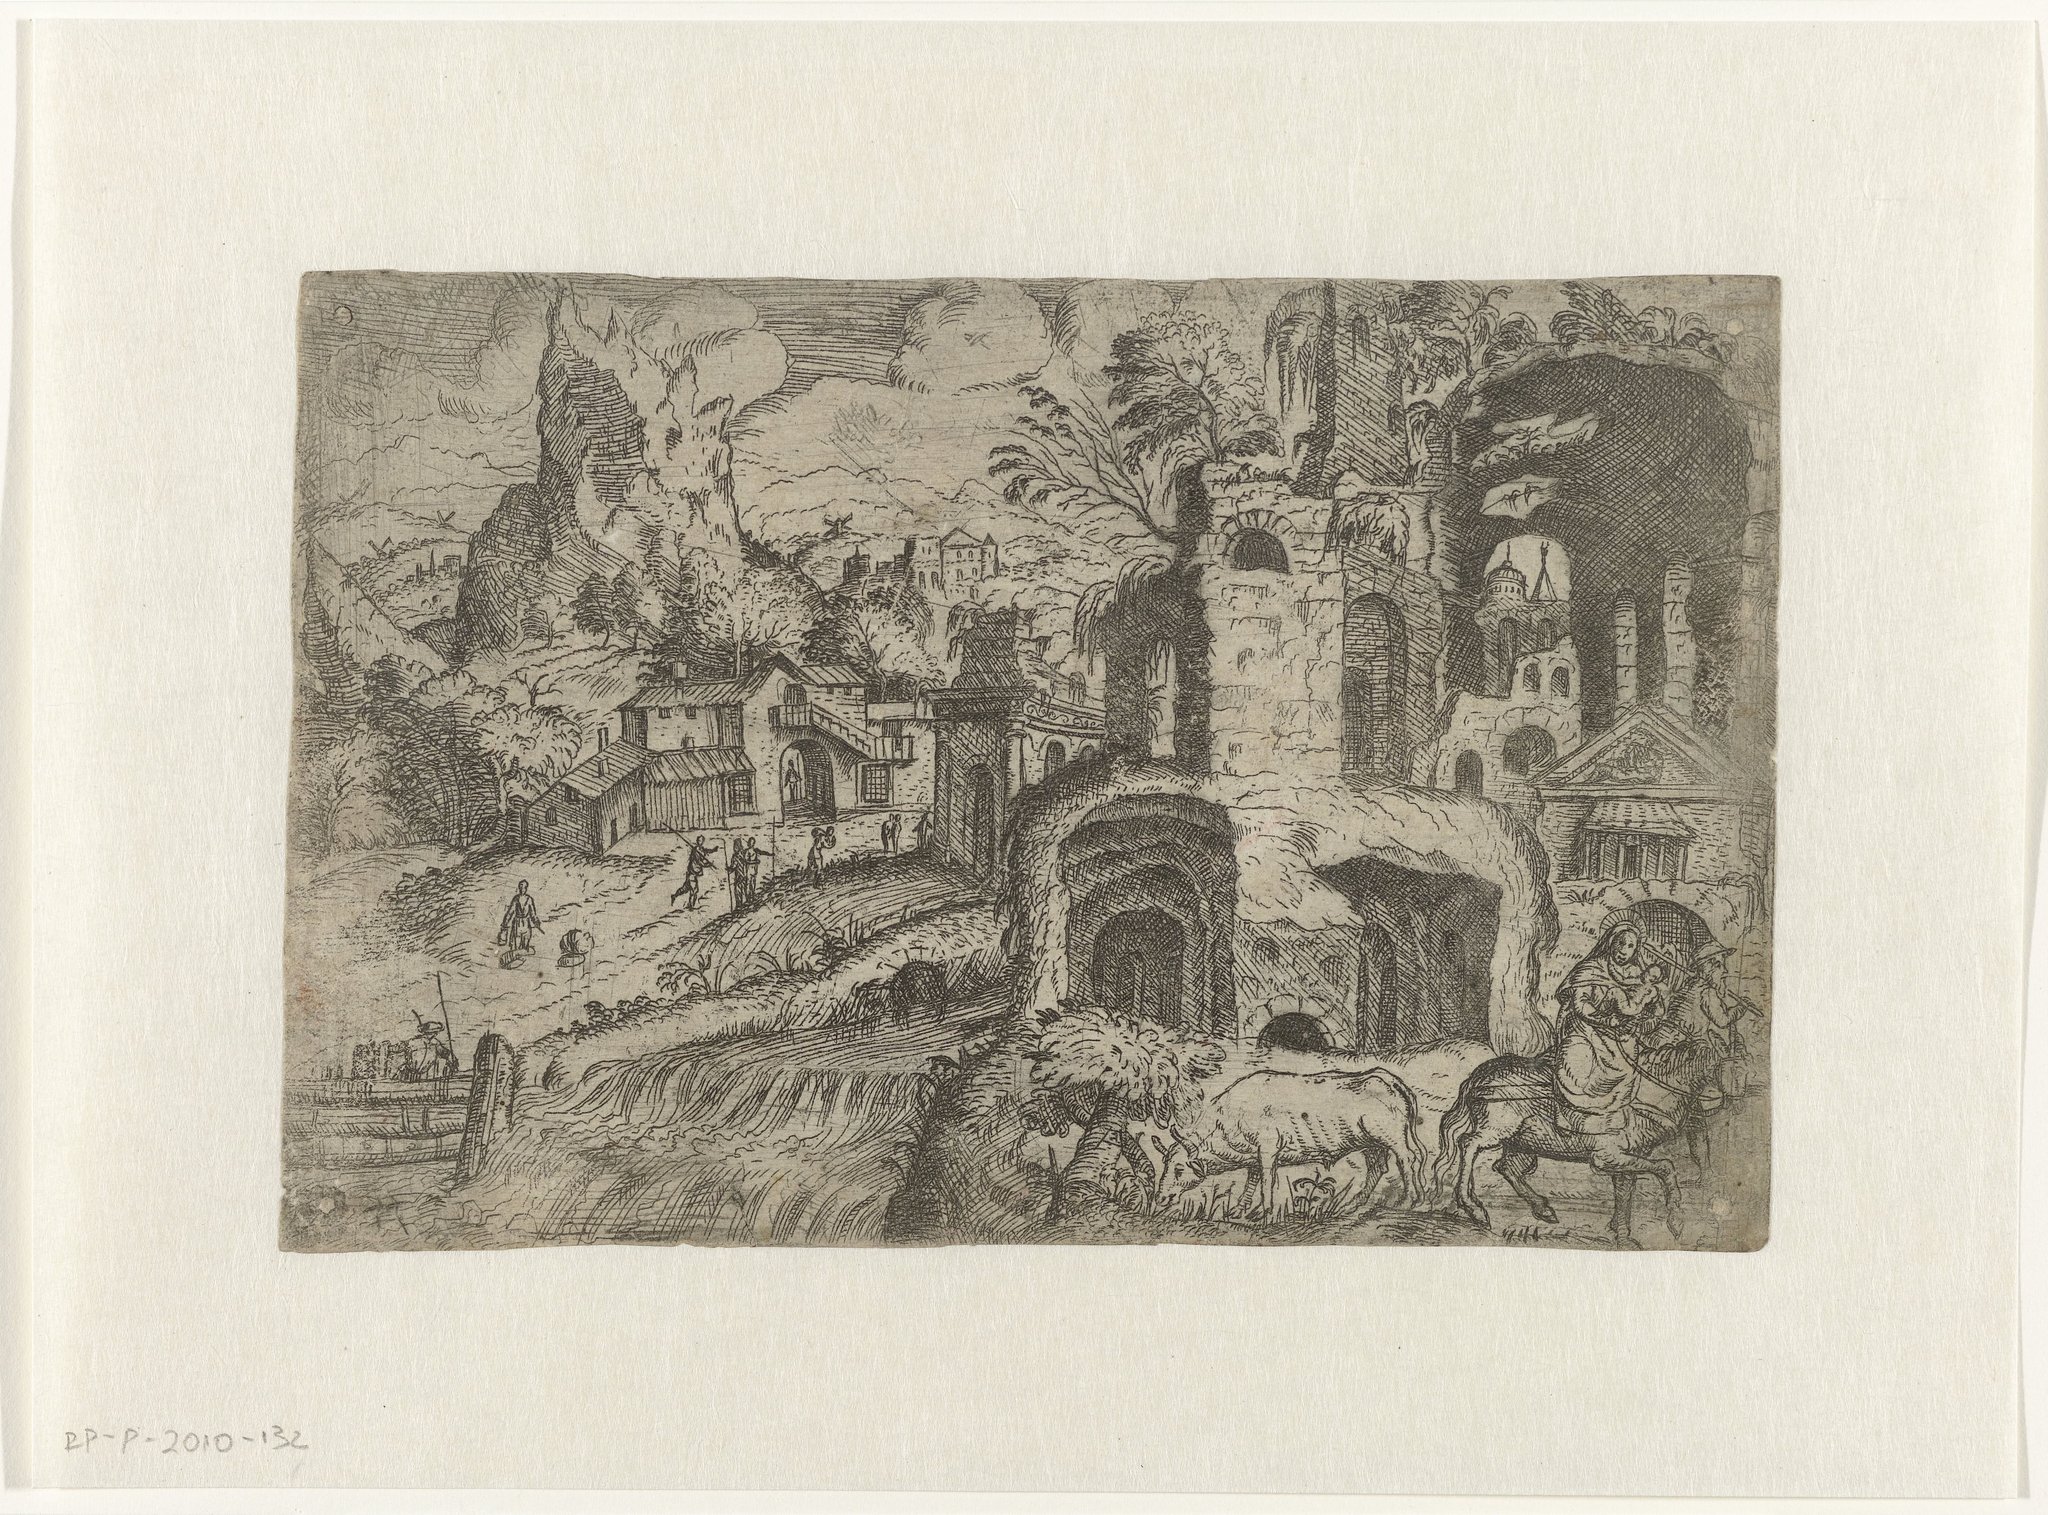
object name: print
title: Landschap met Vlucht naar Egypte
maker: angelo falconetto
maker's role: print maker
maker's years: 1504-1567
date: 1527-1567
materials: paper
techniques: etching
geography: italy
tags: the flight into egypt: mary, joseph, the child (and sometimes others) on their way; mary usually riding on an ass, landscape with ruins - ii - ideal landscapes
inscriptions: collector's mark: Lugt 2228, collector's mark: Lugt 2760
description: Een landschap met antieke ruïnes. Links een open vlakte met enkele hoeves en figuren. Op de achtergrond puntige rotsen. Op de voorgrond rechts een grazende koe, Maria op een ezel en Jozef.